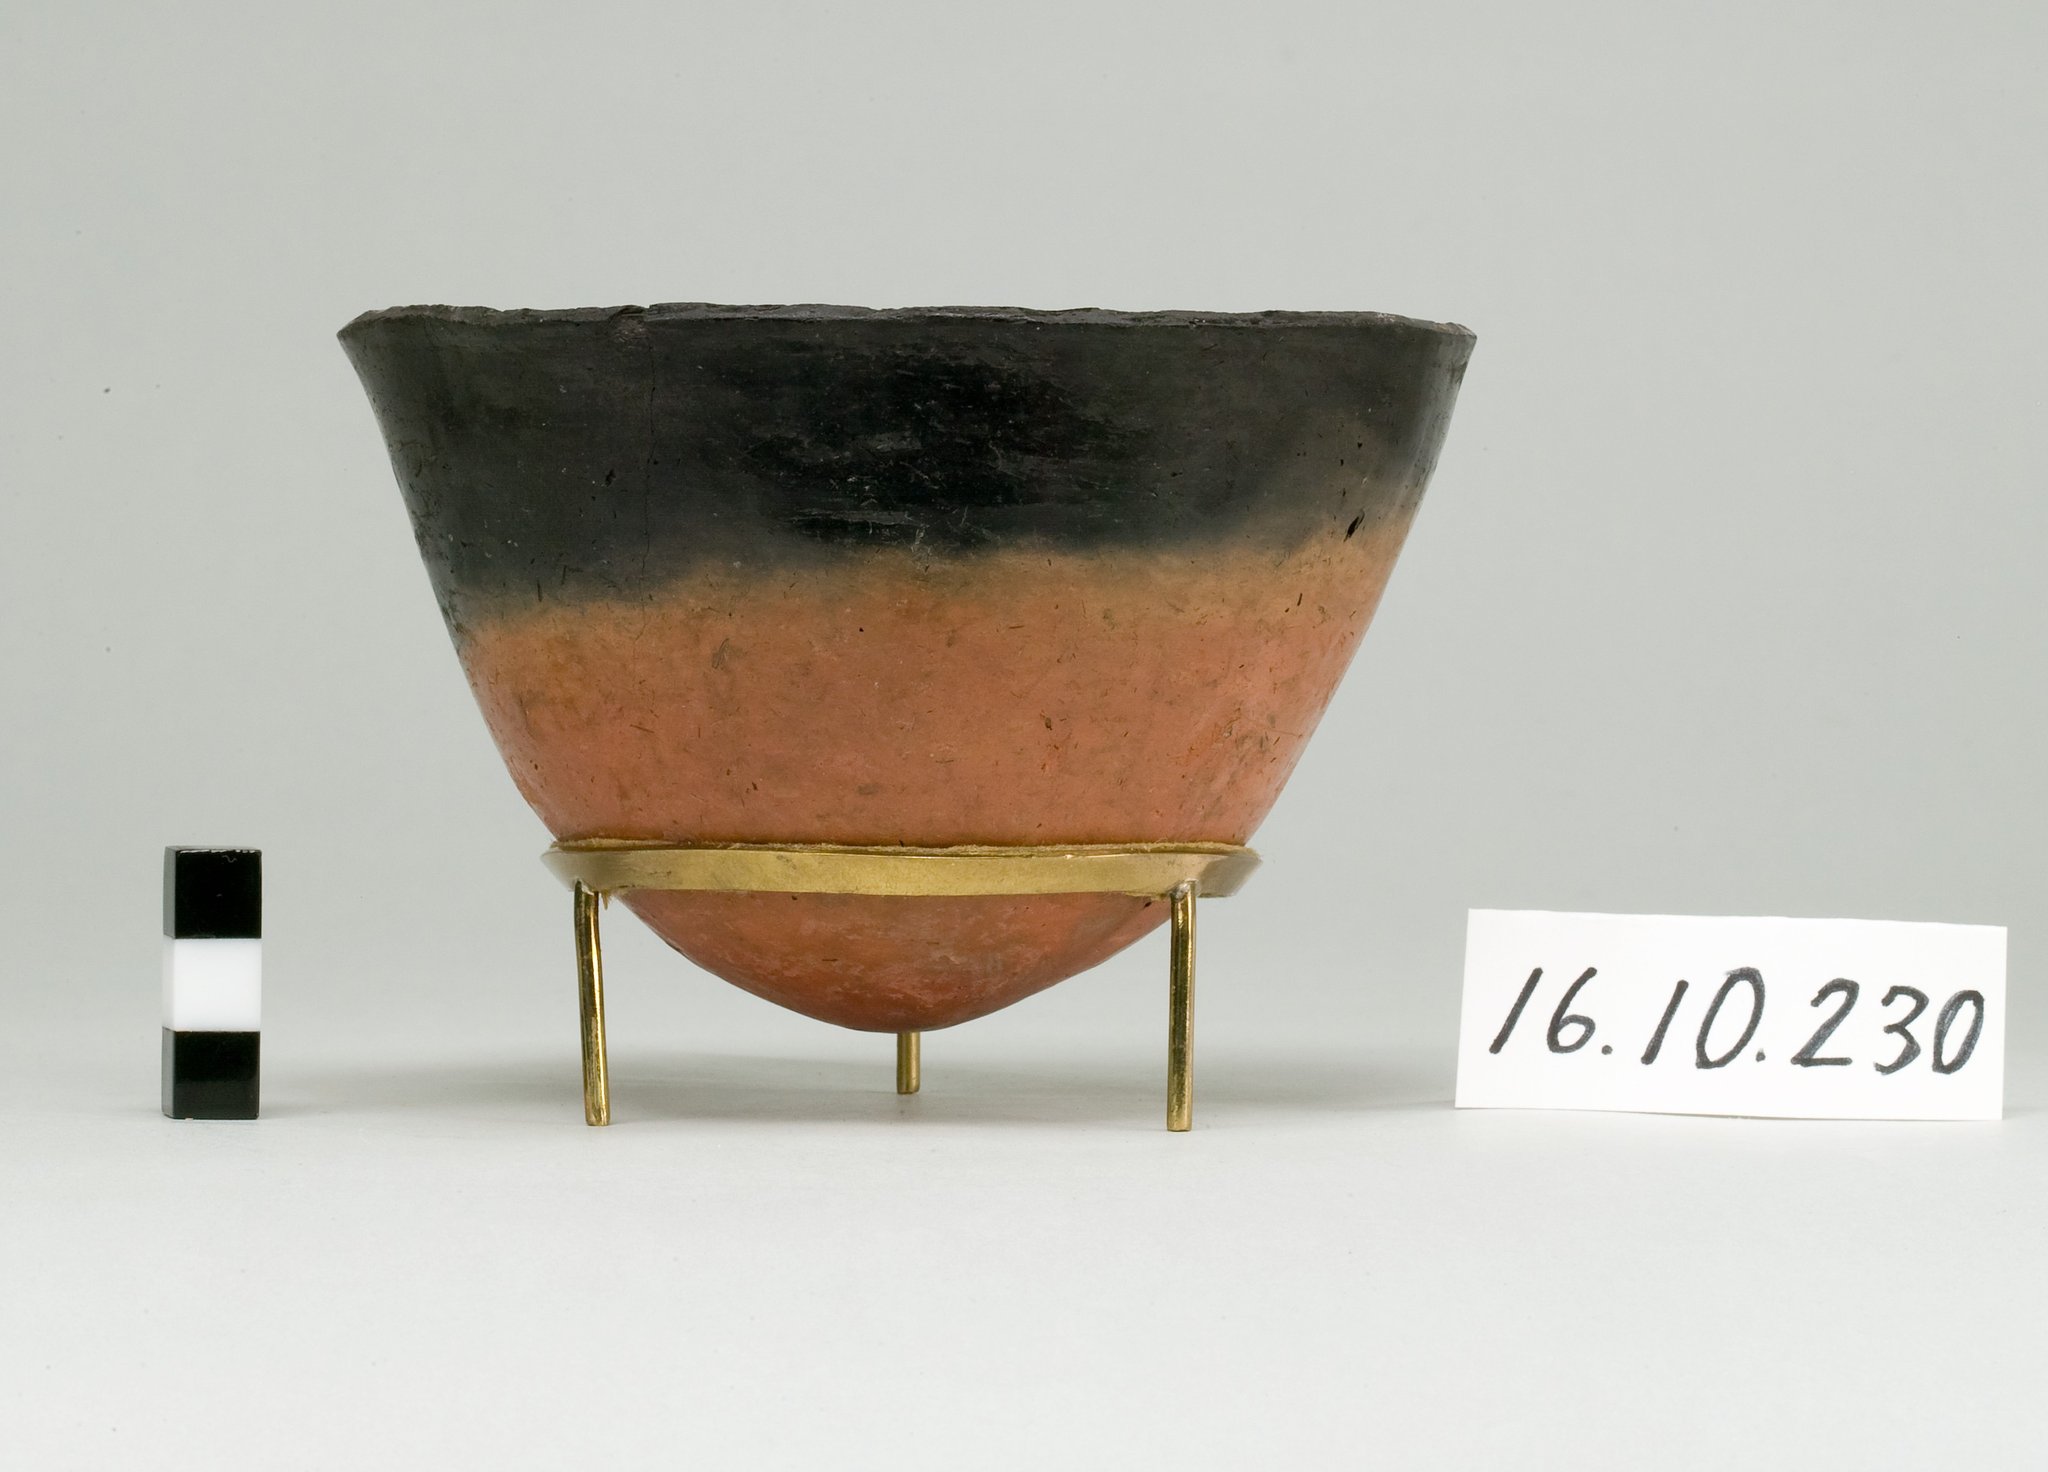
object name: bowl, kerma ware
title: Kerma ware bowl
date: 1635-1458 BCE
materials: pottery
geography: egypt